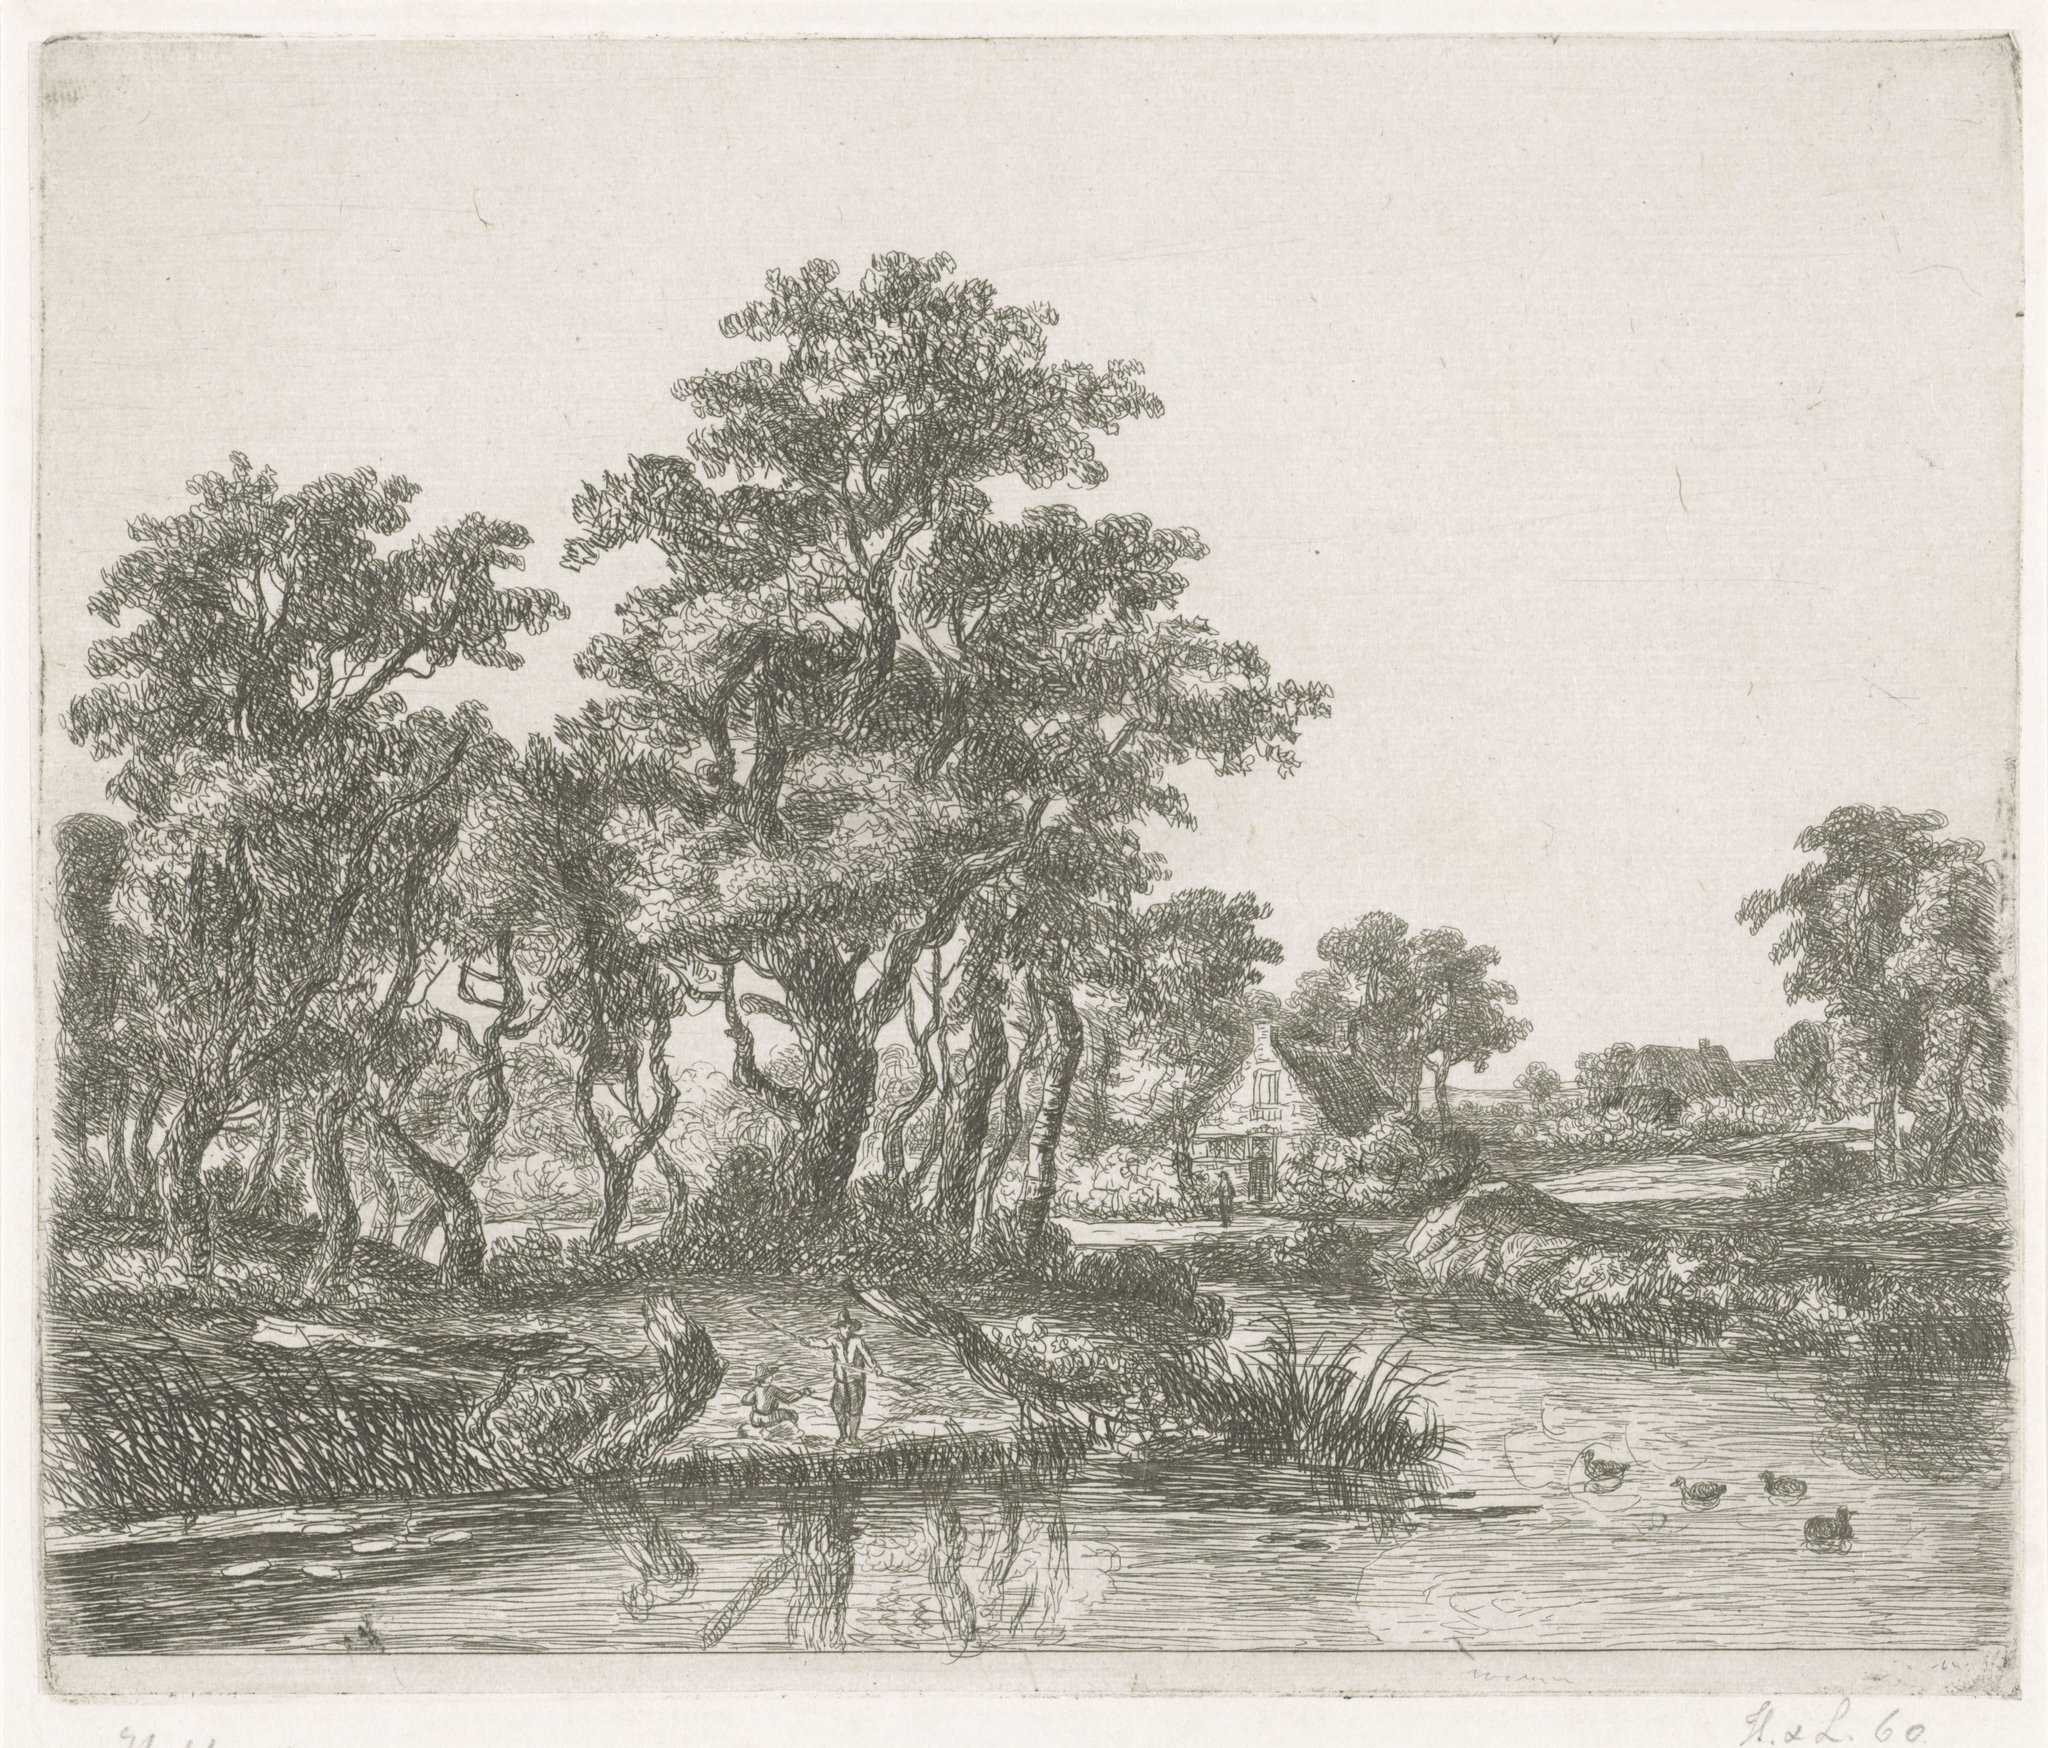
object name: print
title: Rivierlandschap met een hengelaar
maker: hermanus jan hendrik van rijkelijkhuysen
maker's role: painter, print maker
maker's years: 1813-1883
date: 1823-1883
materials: paper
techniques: etching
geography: utrecht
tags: trees, river, road, path, water-birds: duck, fisherman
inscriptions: collector's mark: Lugt 2228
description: Een rivier met links een stuk land met hoge bomen, waar zich twee mannen aan de oever van het water bevinden. Een van hen heeft zijn hengel uitgegooid. Rechts aan de overkant loopt een landweg waaraan enige huizen liggen. Op de voorgrond vier eenden.